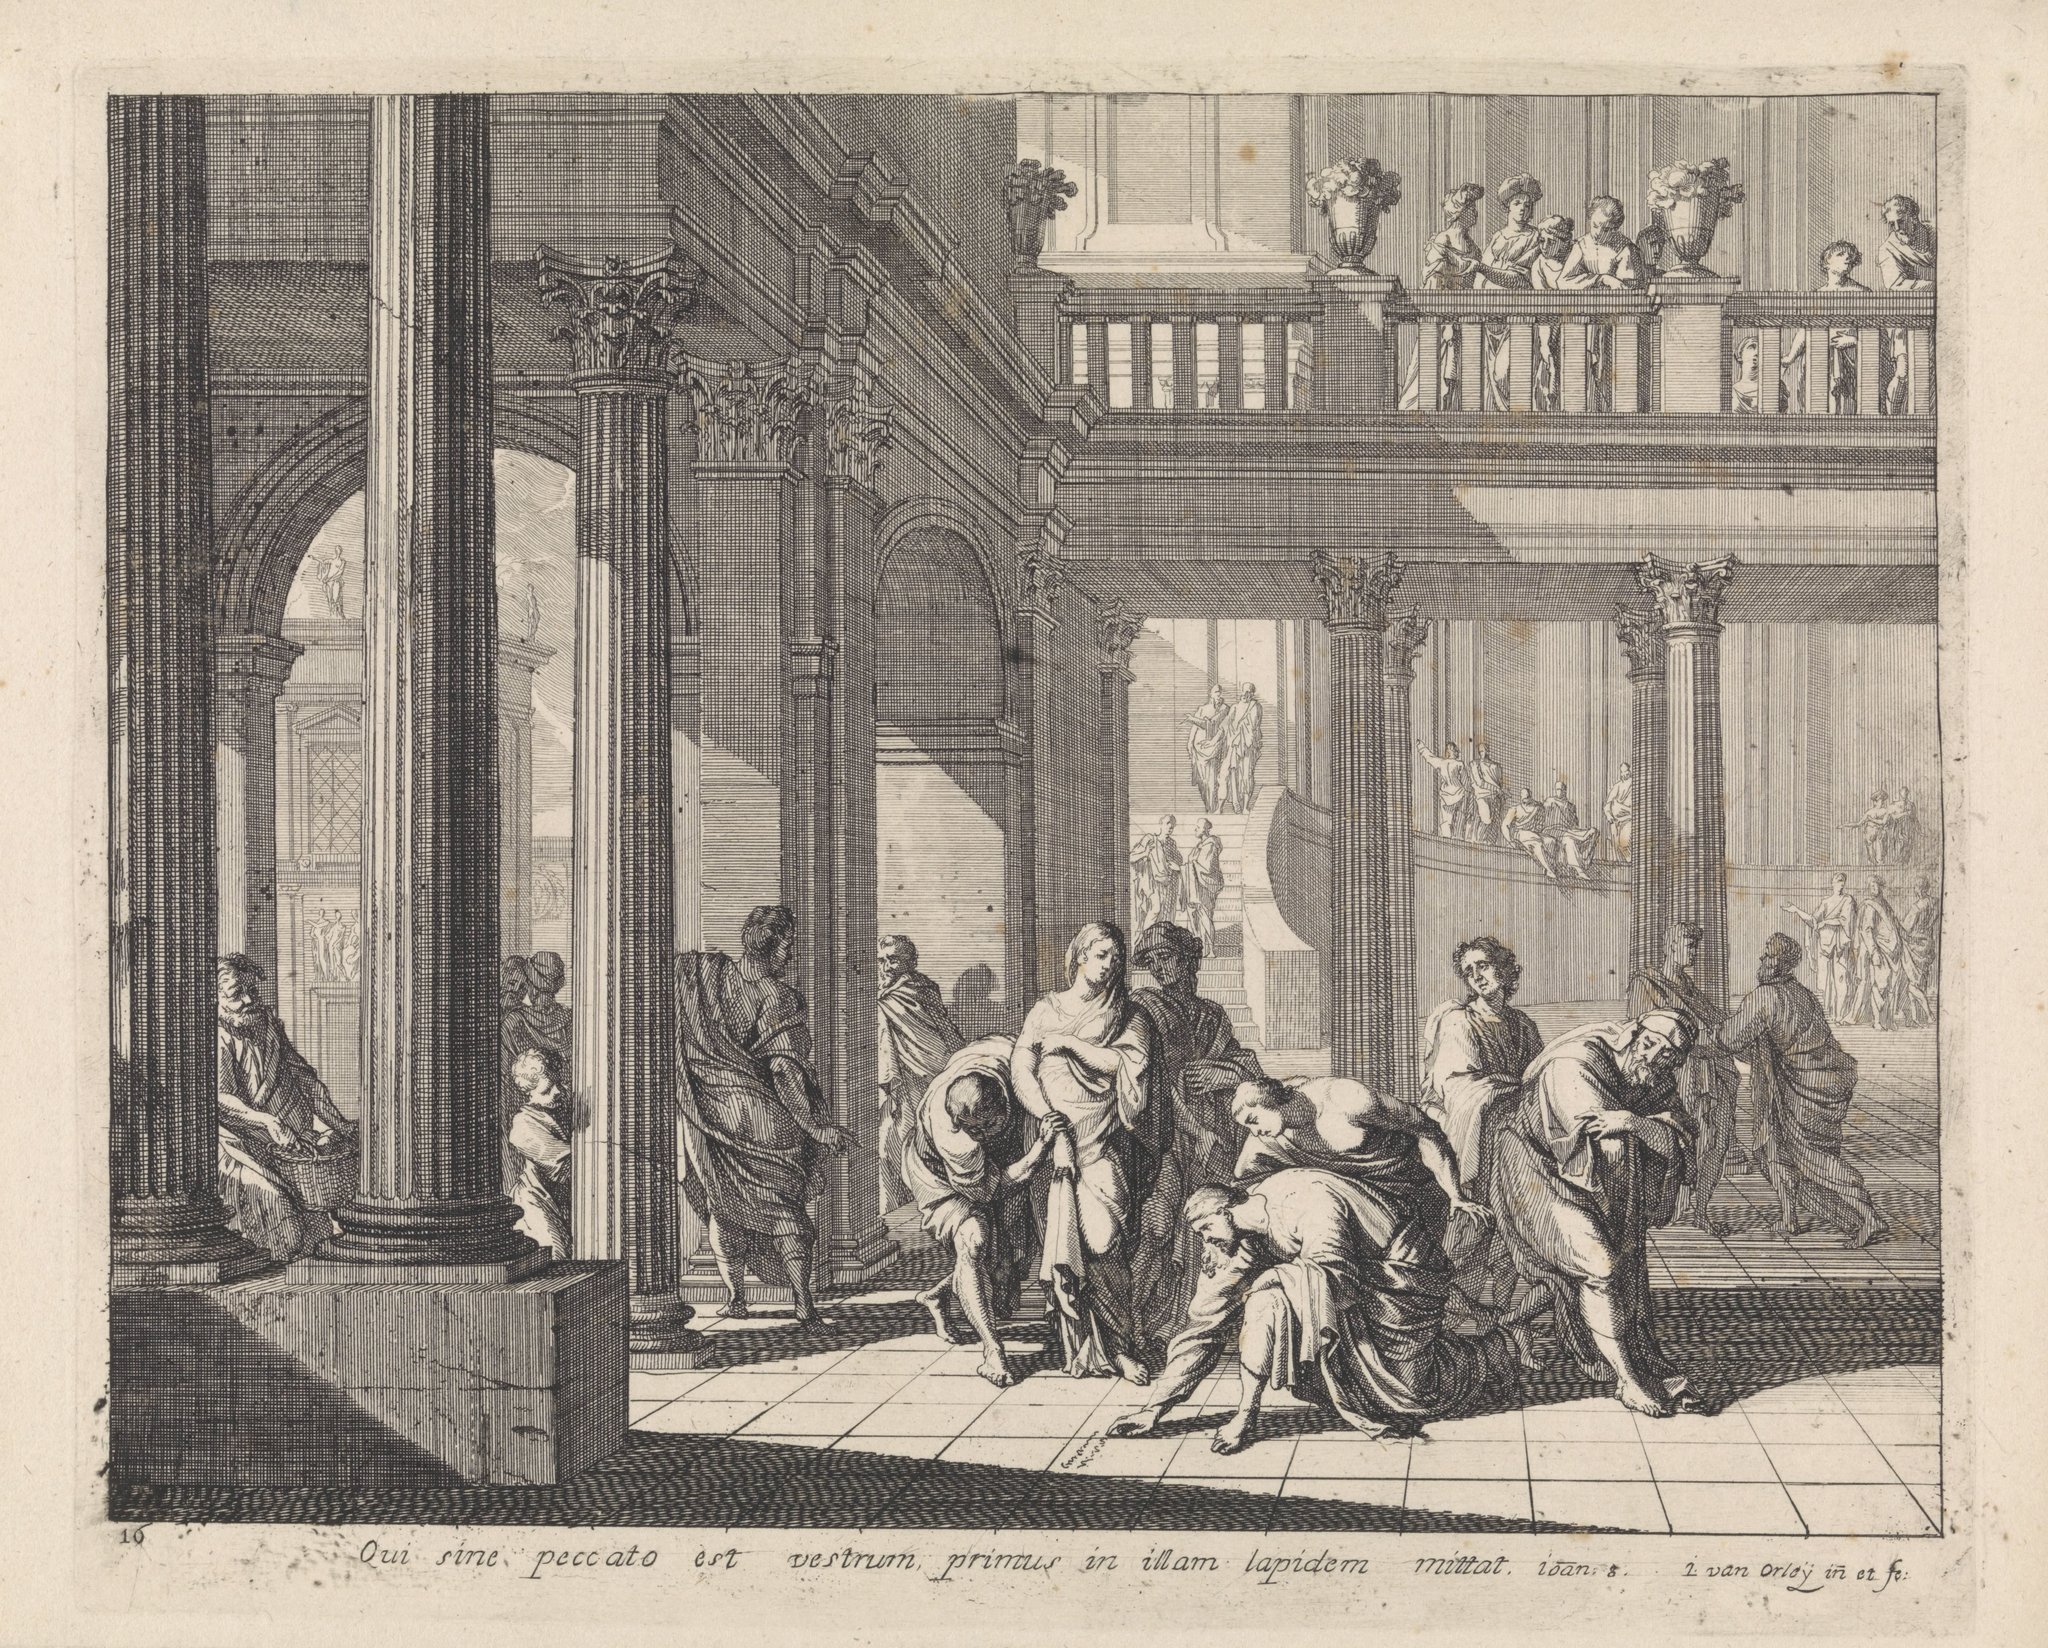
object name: print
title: Scènes uit het Nieuwe Testament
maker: jan van orley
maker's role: print maker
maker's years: 1665-1735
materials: paper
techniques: engraving, etching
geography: brussels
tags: pharisees bring a woman accused of adultery before christ (john 8:2-11)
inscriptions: collector's mark: Lugt 240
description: Terwijl Christus les geeft in de tempel brengen de geleerden hem een overspelige vrouw om over haar te oordelen. Christus bukt en schrijft met zijn vinger op de grond: ‘Wie van jullie zonder zonde is, laat die als eerste een steen naar haar werpen’. Onder de afbeelding dit vers, afkomstig uit Joh. 8, in het Latijn.